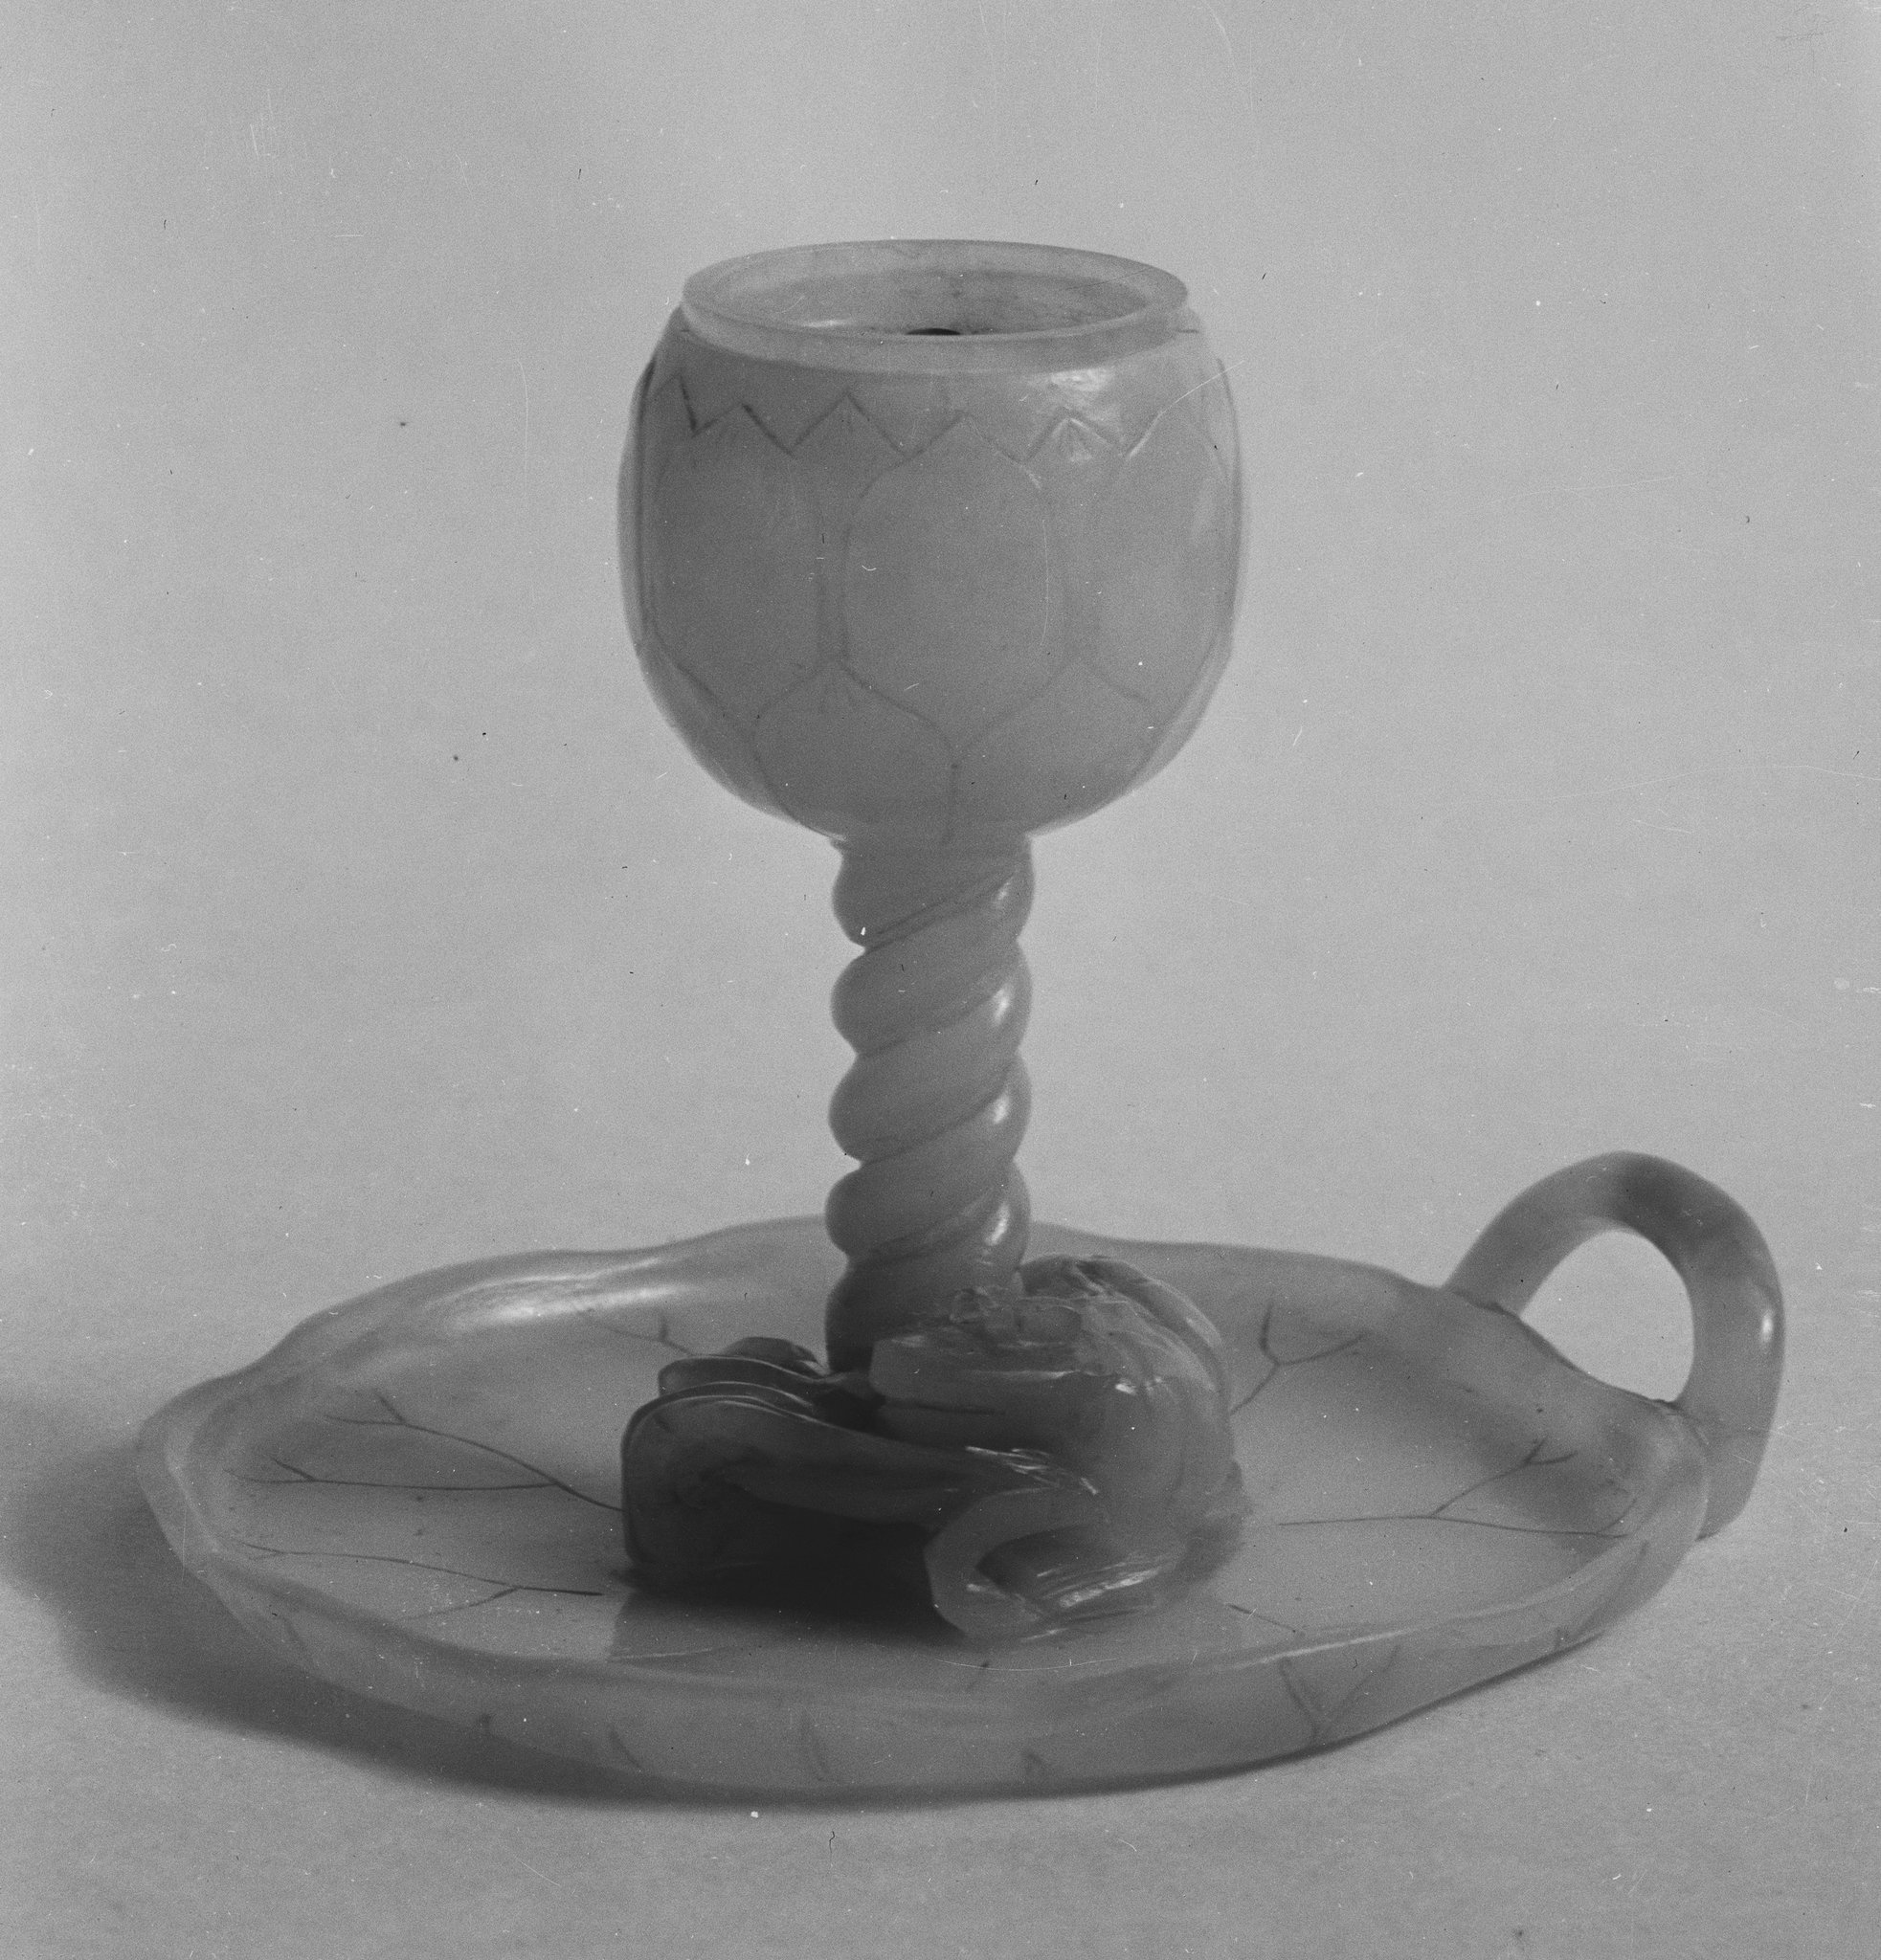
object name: oil lamp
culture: chinese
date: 1701-1800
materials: jade